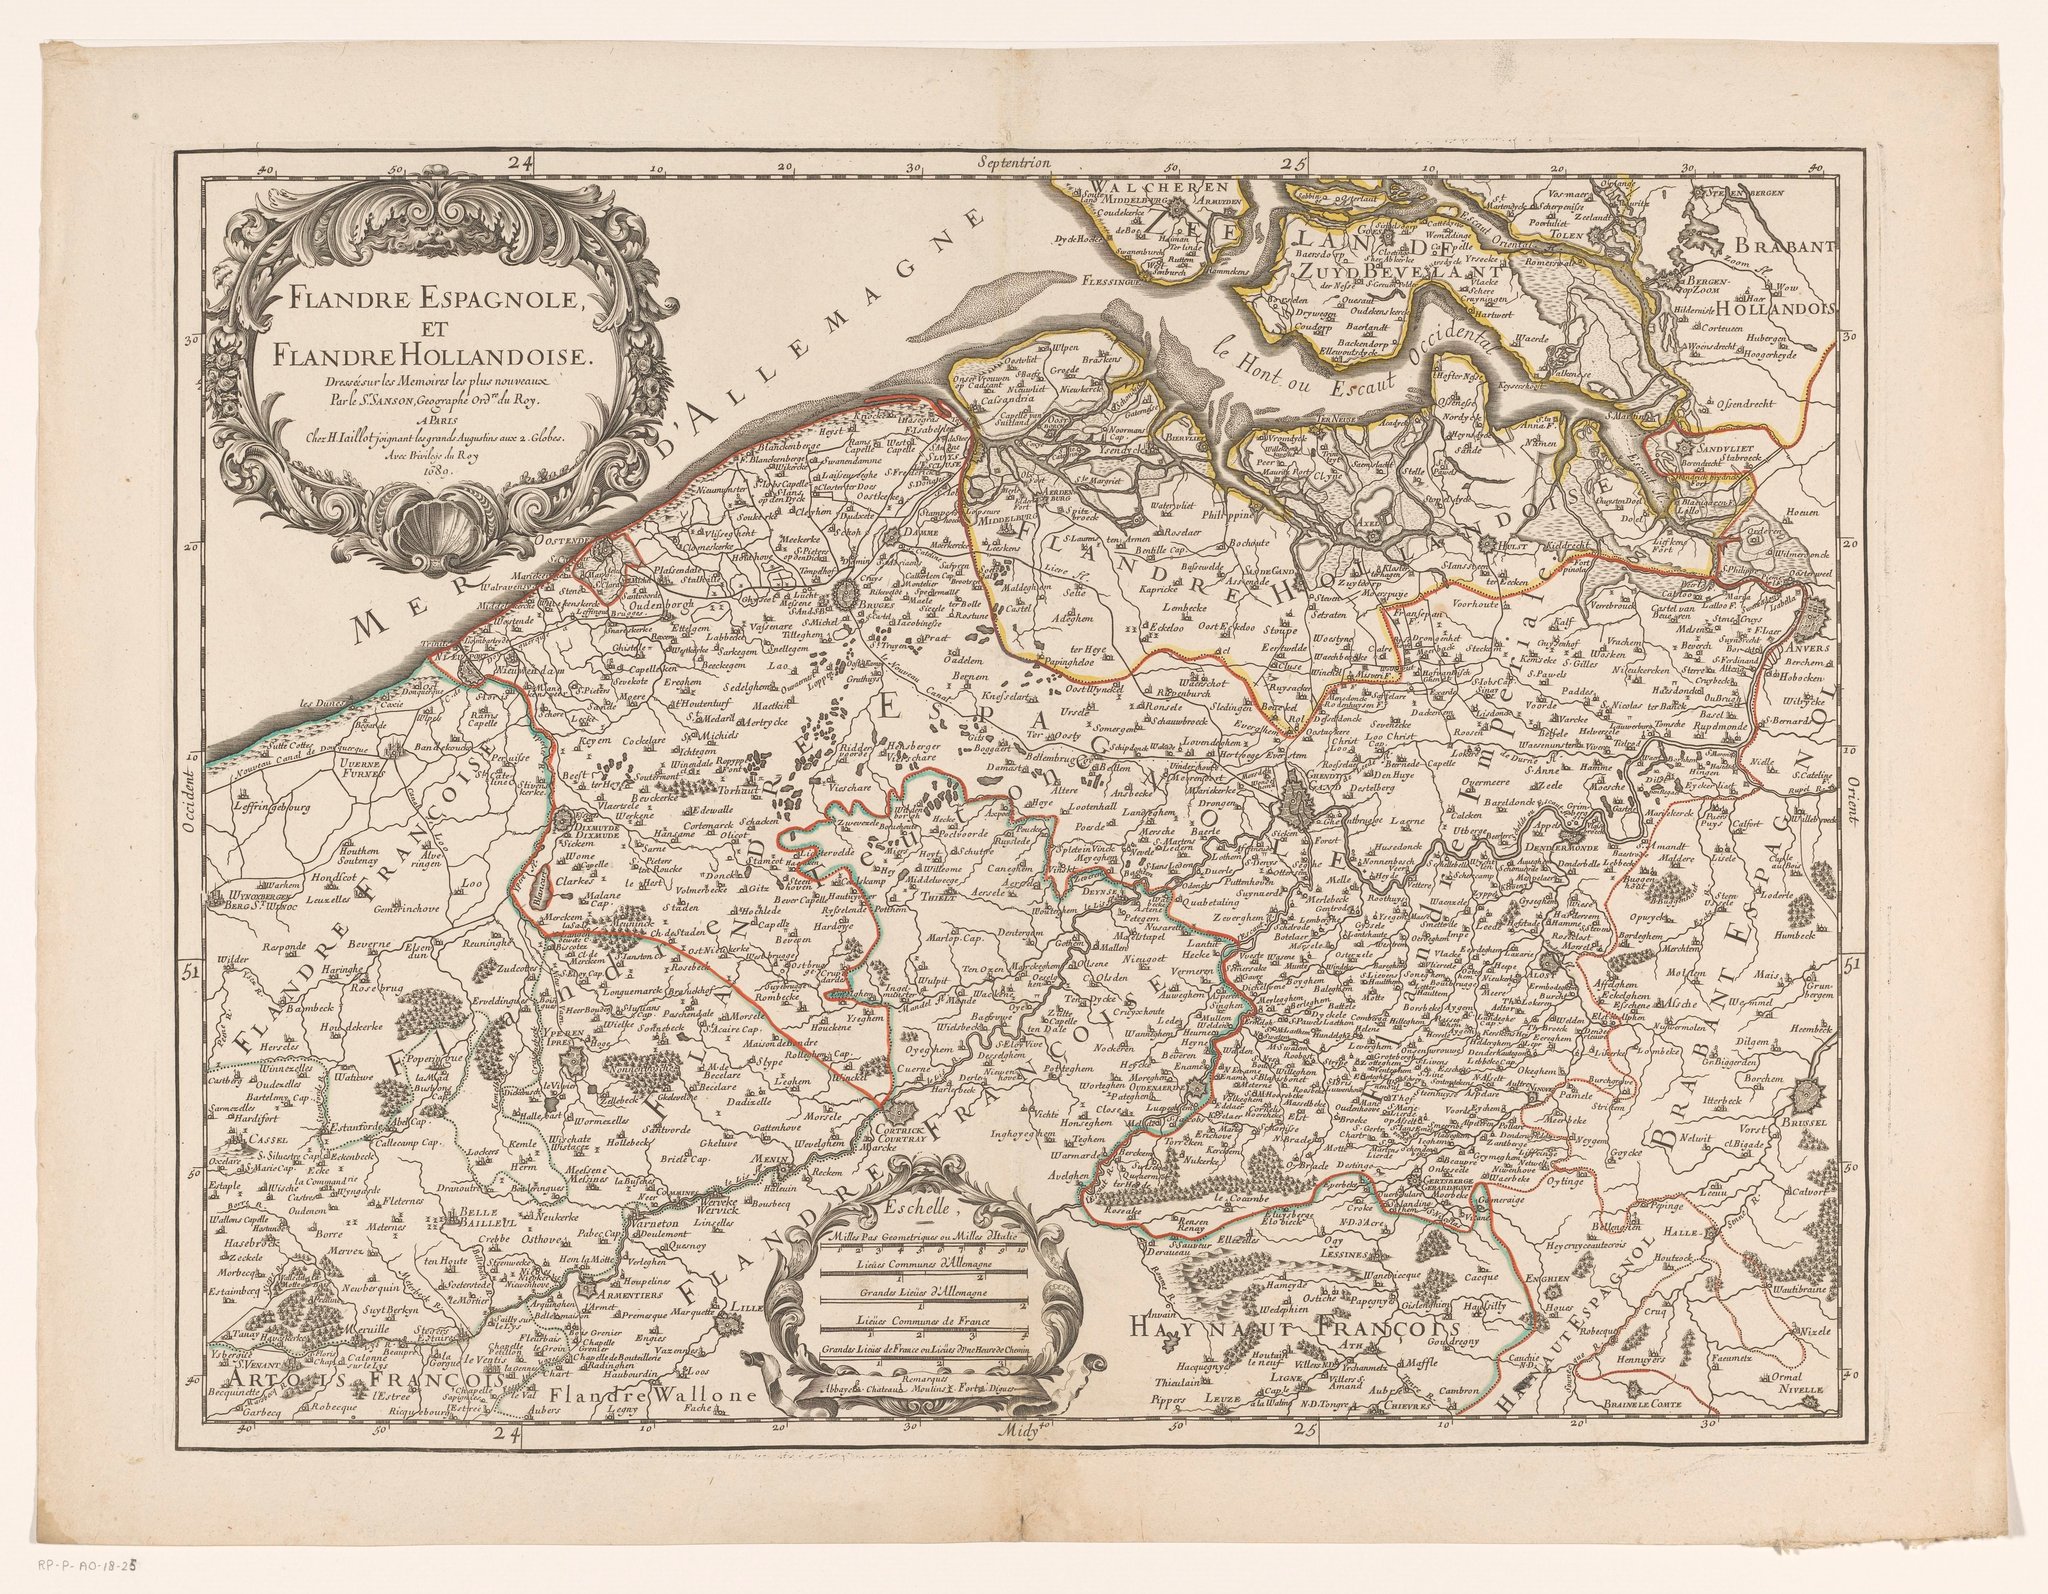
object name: print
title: Kaart van het Spaanse en Hollandse deel van Vlaanderen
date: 1689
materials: paper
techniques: engraving, etching, hand coloring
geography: paris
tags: maps of separate countries or regions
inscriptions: collector's mark: Lugt 195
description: Kaart van het Spaanse en Hollandse deel van Vlaanderen. Linksboven de titelcartouche. Onder, links van het midden, een cartouche met legenda en vijf schaalstokken: 10 Milles Pas Geometriques ou Milles d'Italie / 2 Lieues Comunes d'Allemagne, en nog drie andere. De kaart is voorzien van een gradenverdeling langs de randen.